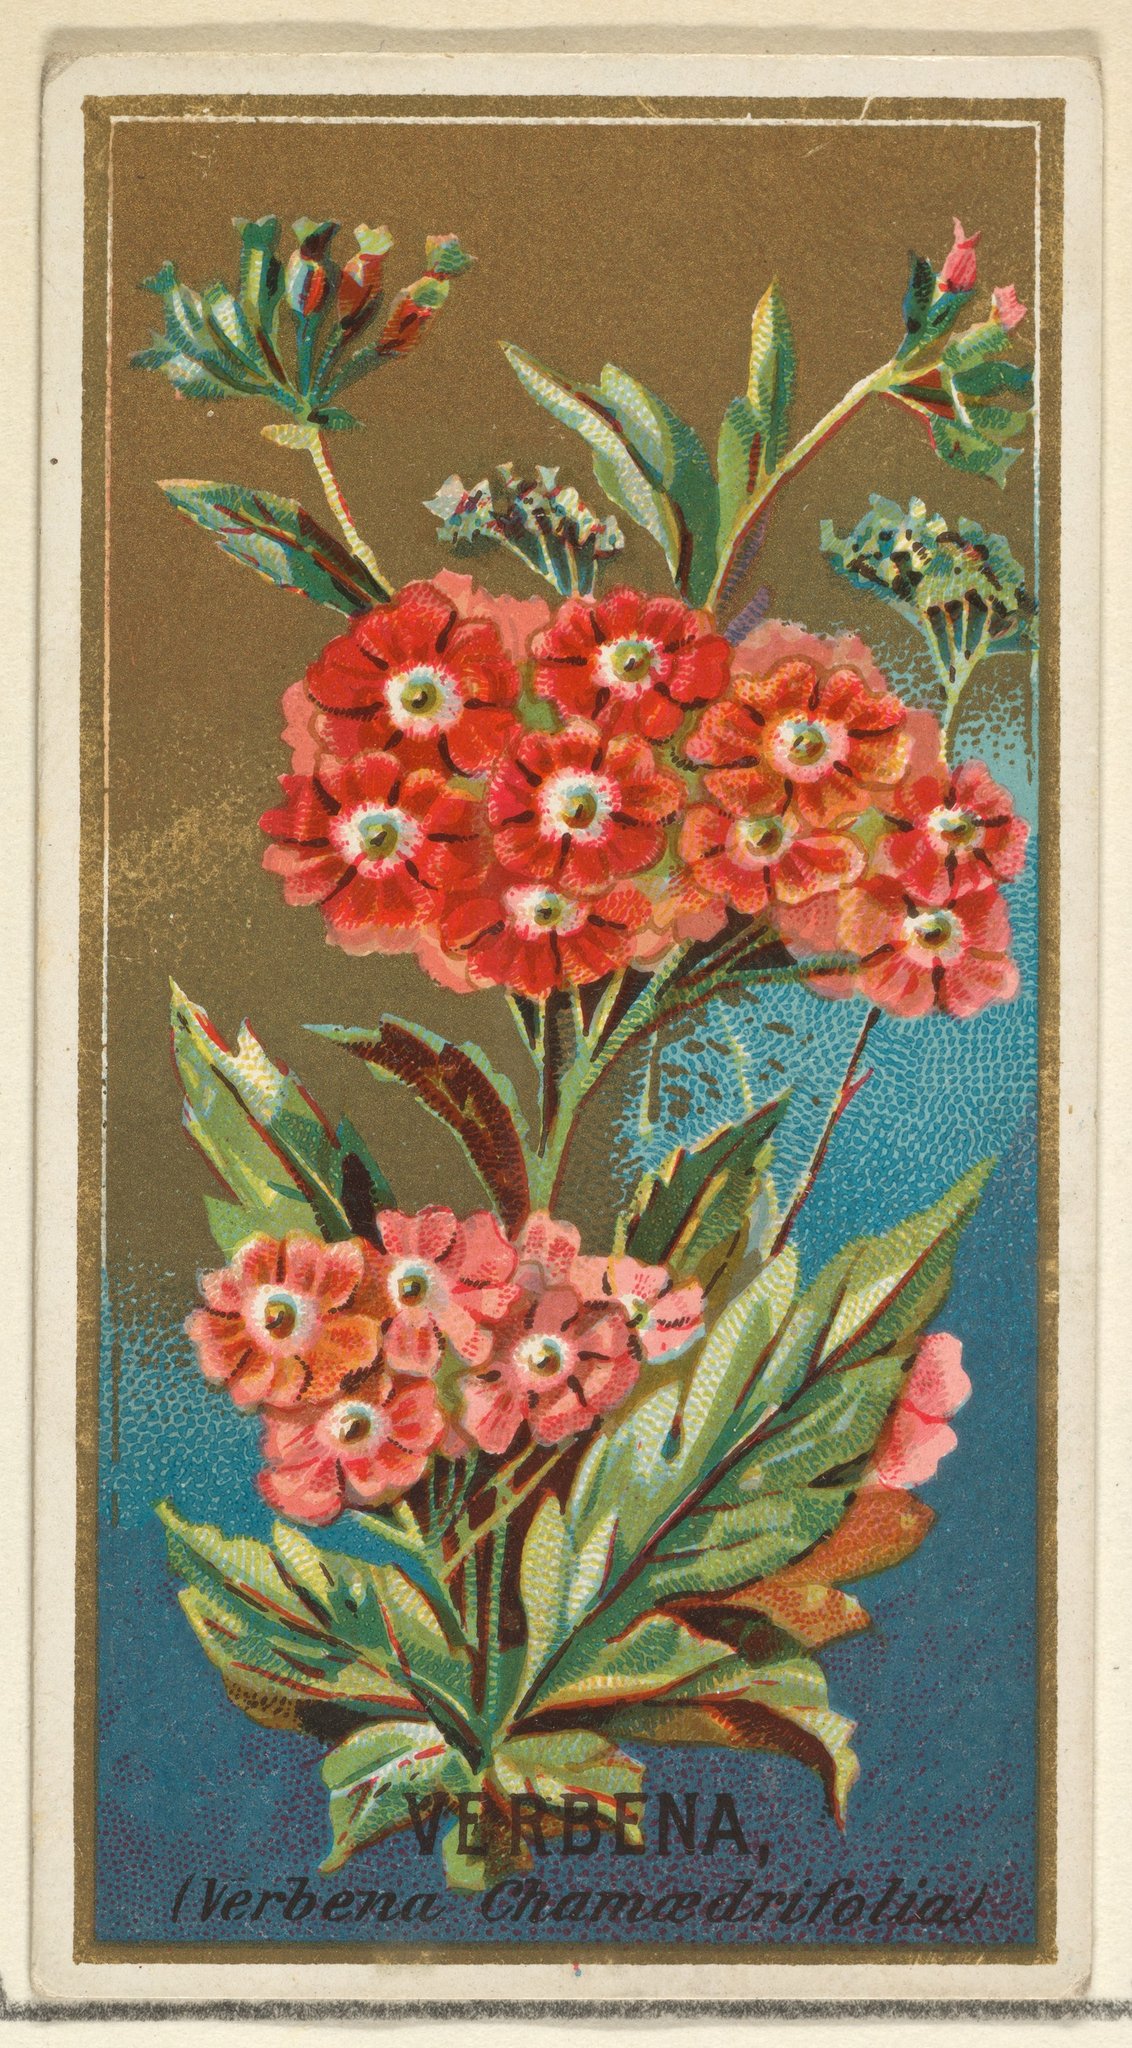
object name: print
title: Verbena (Verbena chamaedrifolia), from the Flowers series for Old Judge Cigarettes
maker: goodwin & company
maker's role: publisher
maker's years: 1850-1950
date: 1890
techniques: color lithograph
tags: flowers,leaves